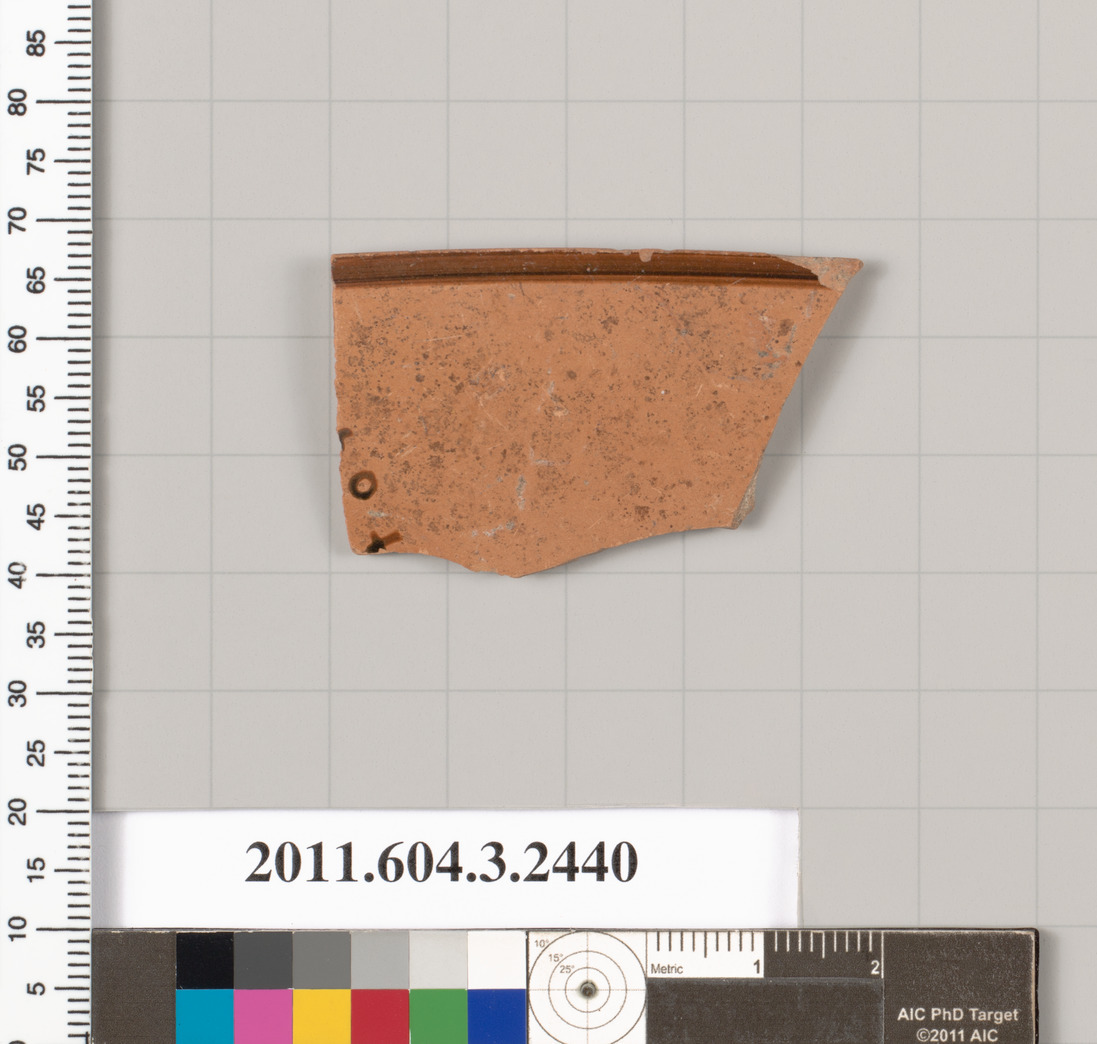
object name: kylix fragment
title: Terracotta rim fragment of a kylix (drinking cup)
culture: greek, attic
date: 534-468 BCE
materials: terracotta